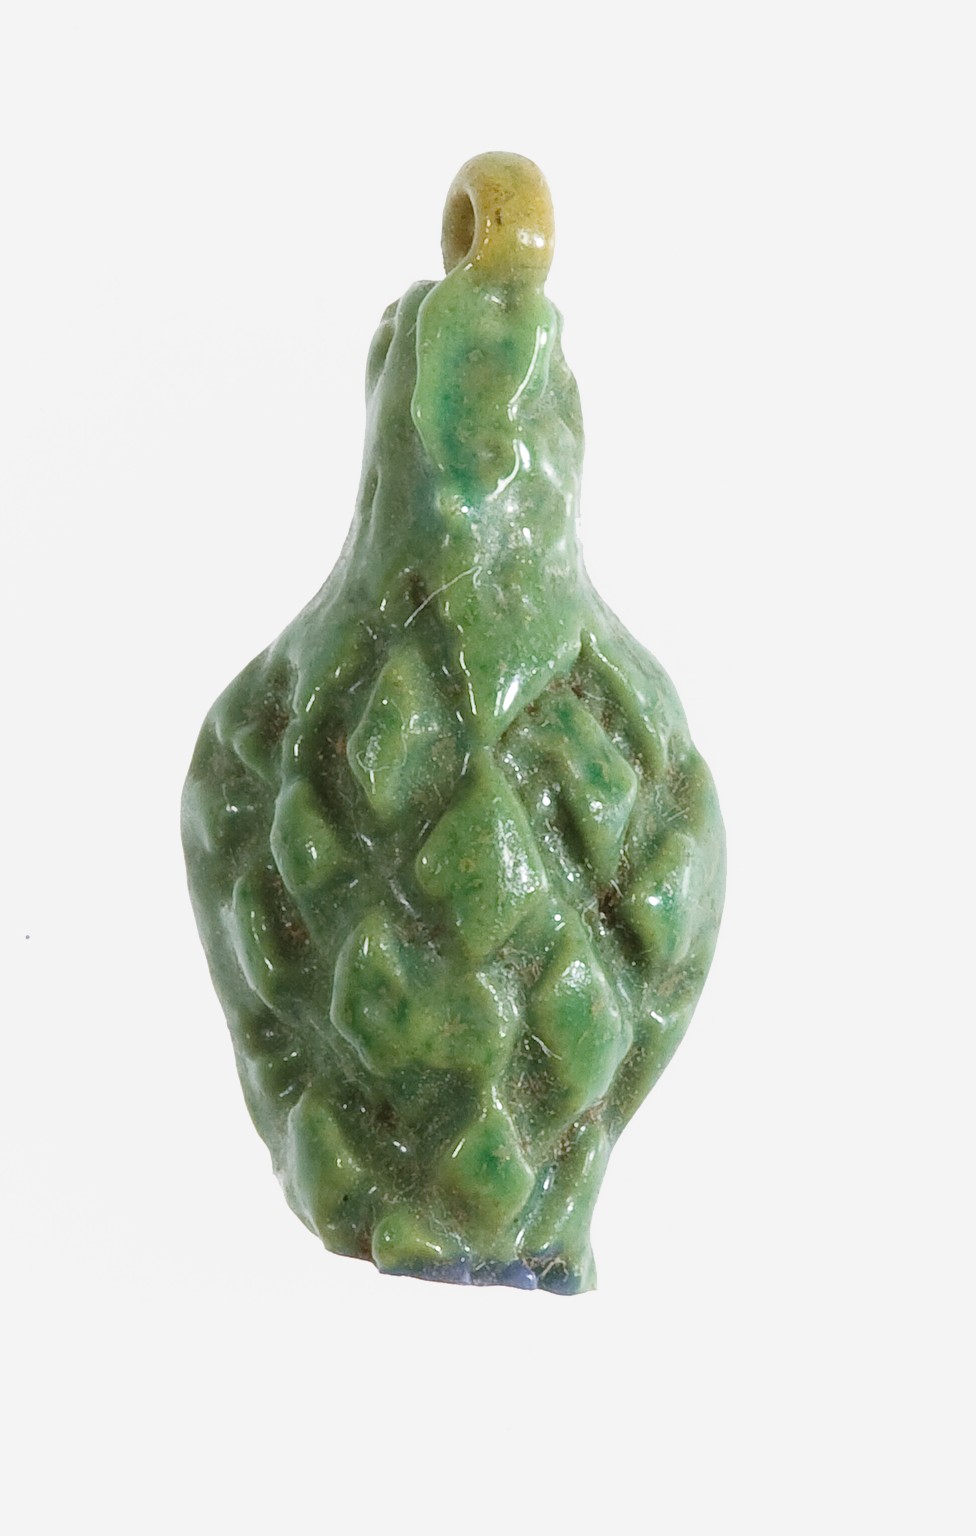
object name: pendant, cornflower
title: Cornflower Pendant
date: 1390-1352 BCE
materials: faience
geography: egypt